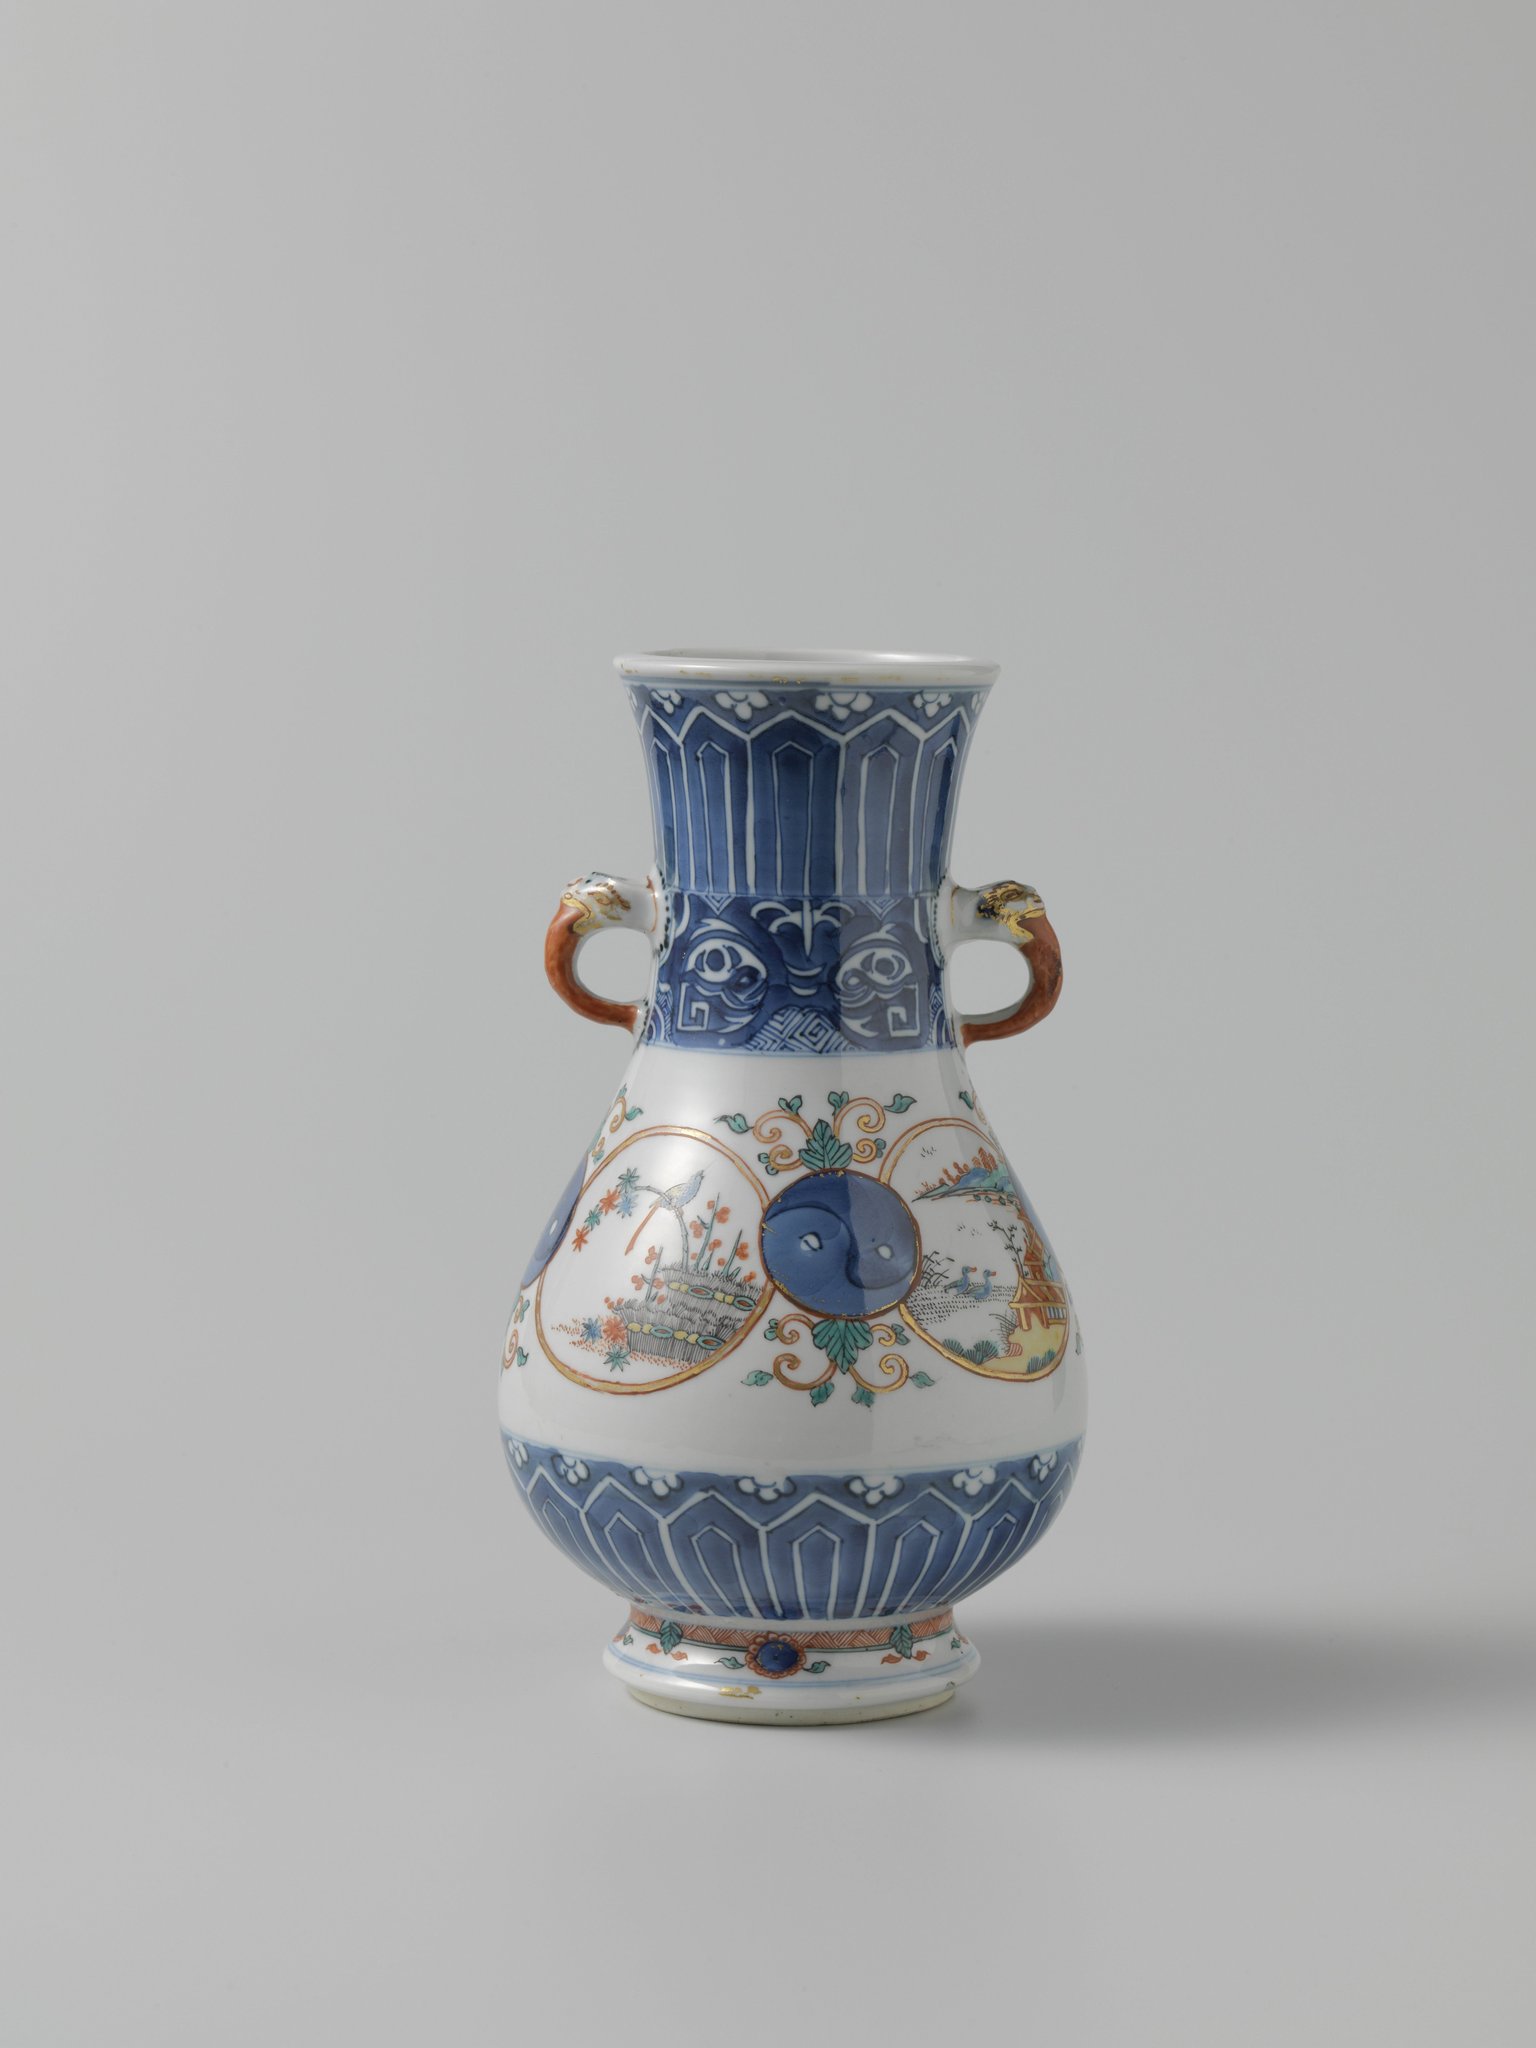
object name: vase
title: Pear-shaped vase with ornamental borders and landscapes in medallions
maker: Anonymous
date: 1700-1724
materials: cobalt, glaze, gold, paint, porcelain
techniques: firing, gilding, turning, vitrification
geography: europe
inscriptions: mark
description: Four vases. China, c. 1690 - 1710, decorated, c. 1710 - 1725.